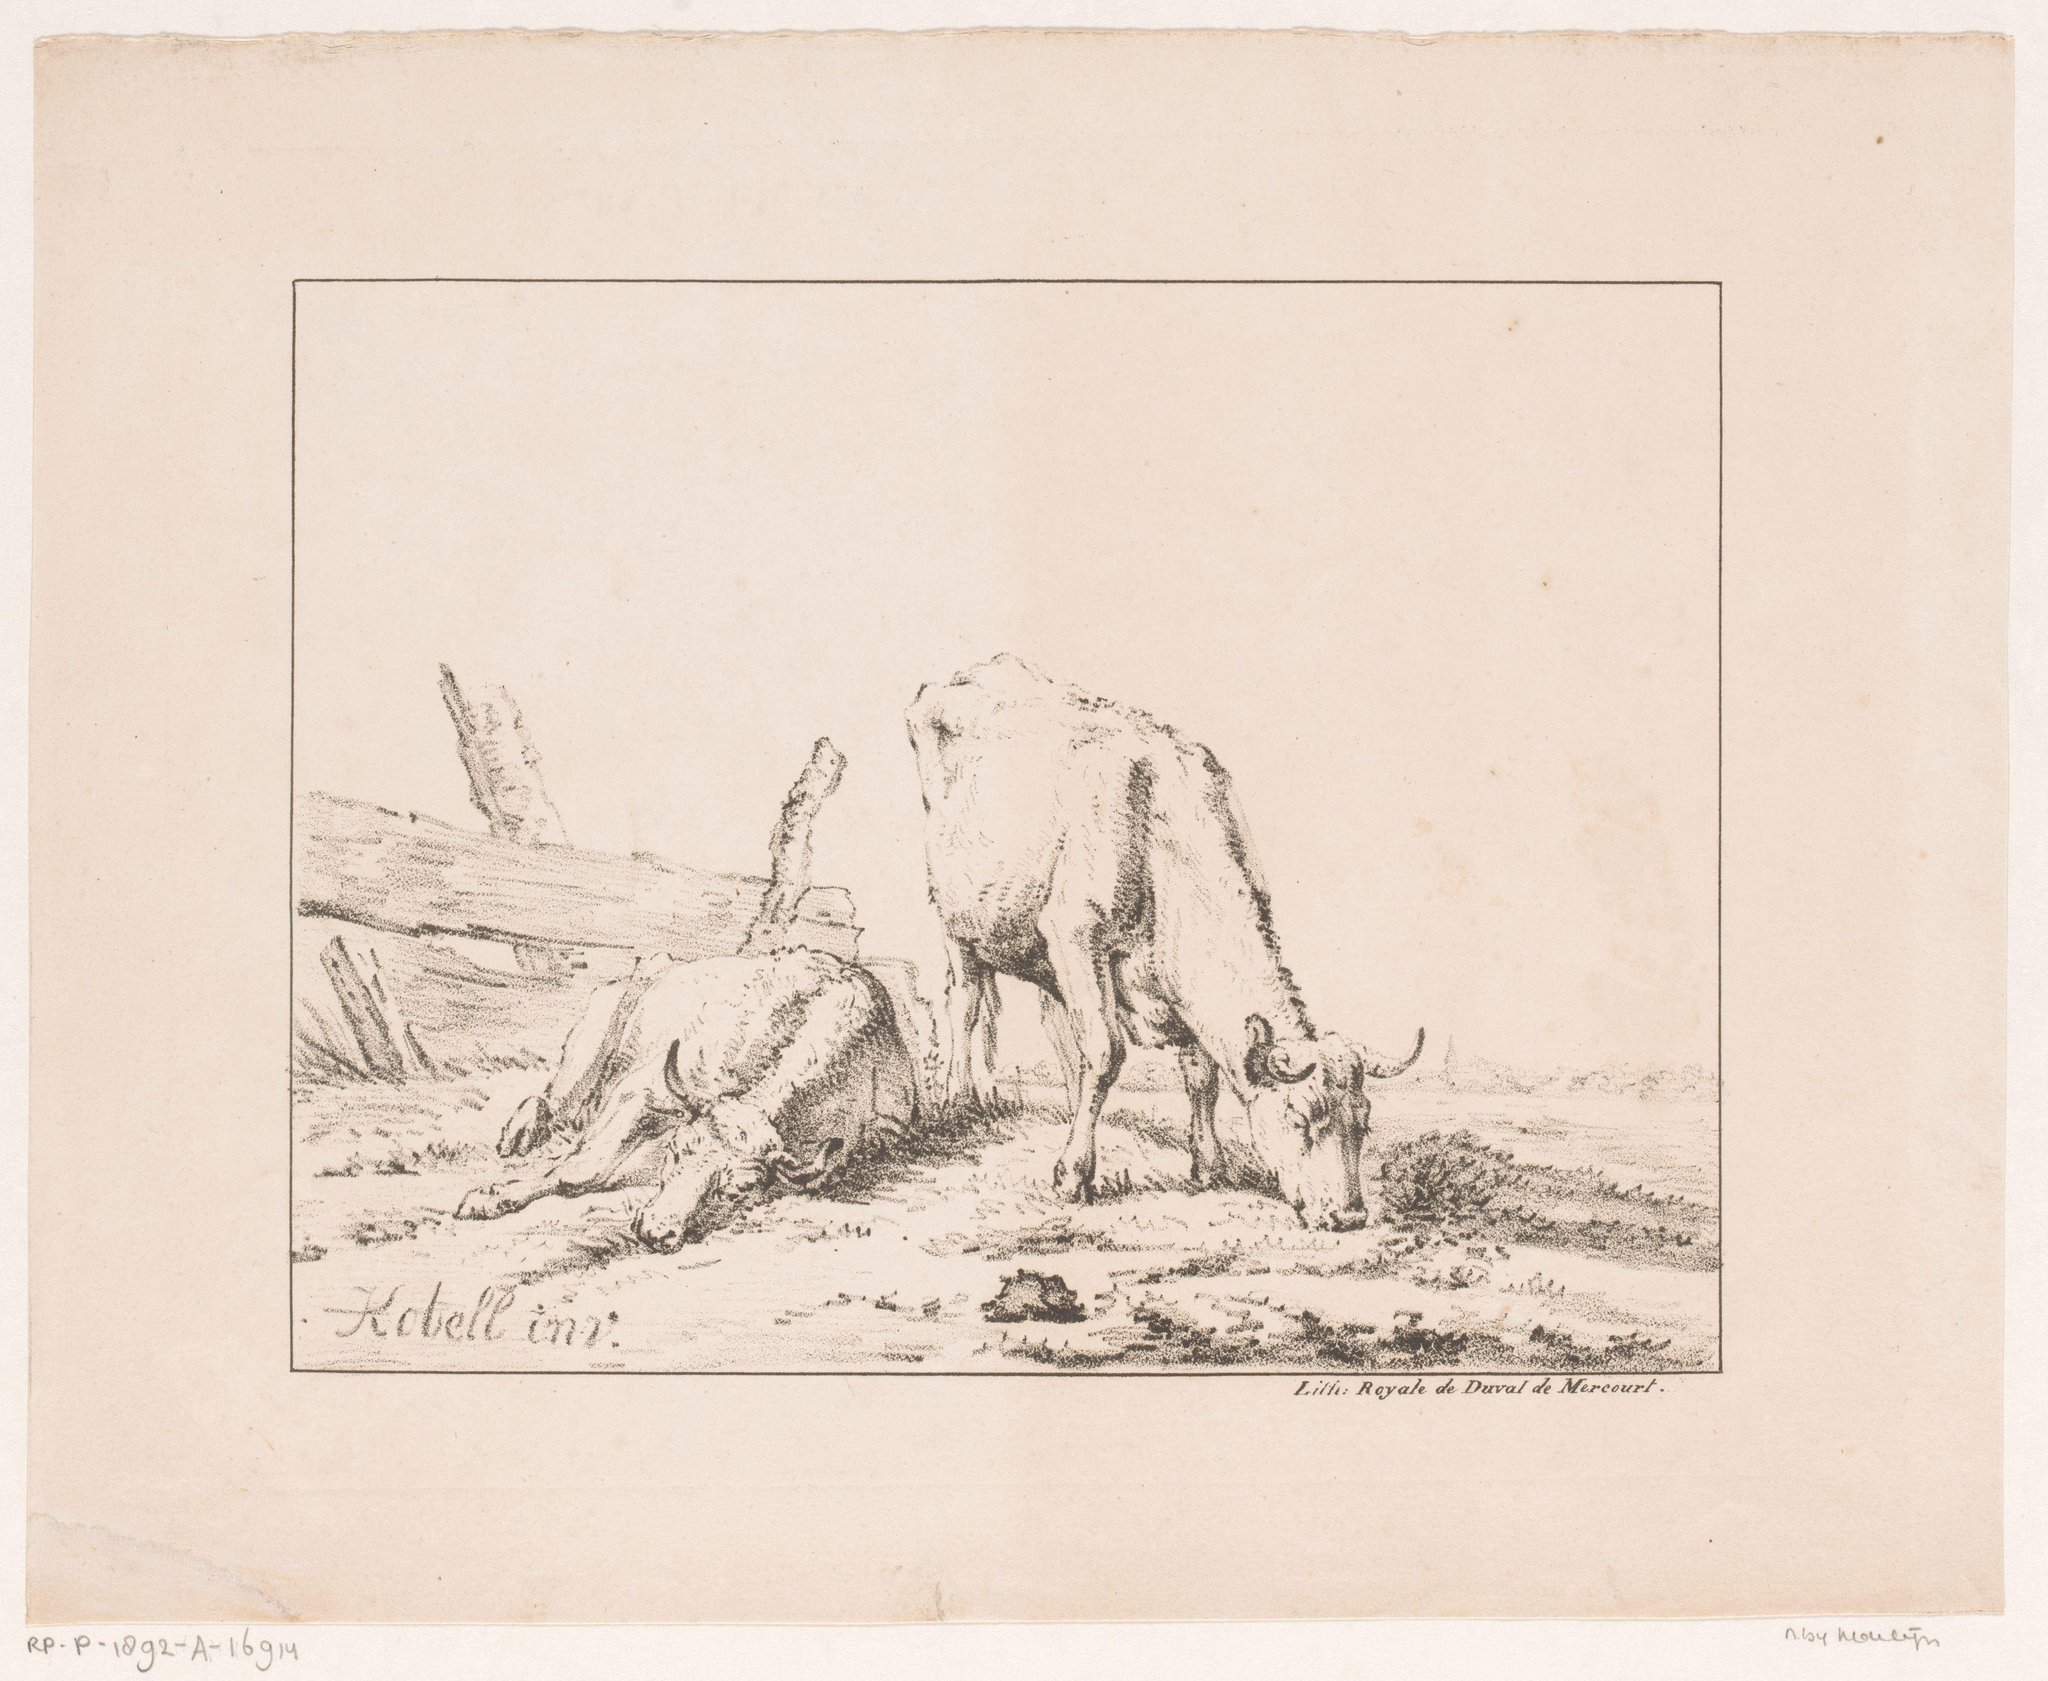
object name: print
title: Twee koeien in een weide bij een hek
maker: m. j. v. duval de mercourt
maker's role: print maker, printer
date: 1818-1819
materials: paper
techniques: lithograph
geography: the hague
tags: cow, landscapes in the temperate zone, fence, wall, paling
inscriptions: collector's mark: Lugt 2228